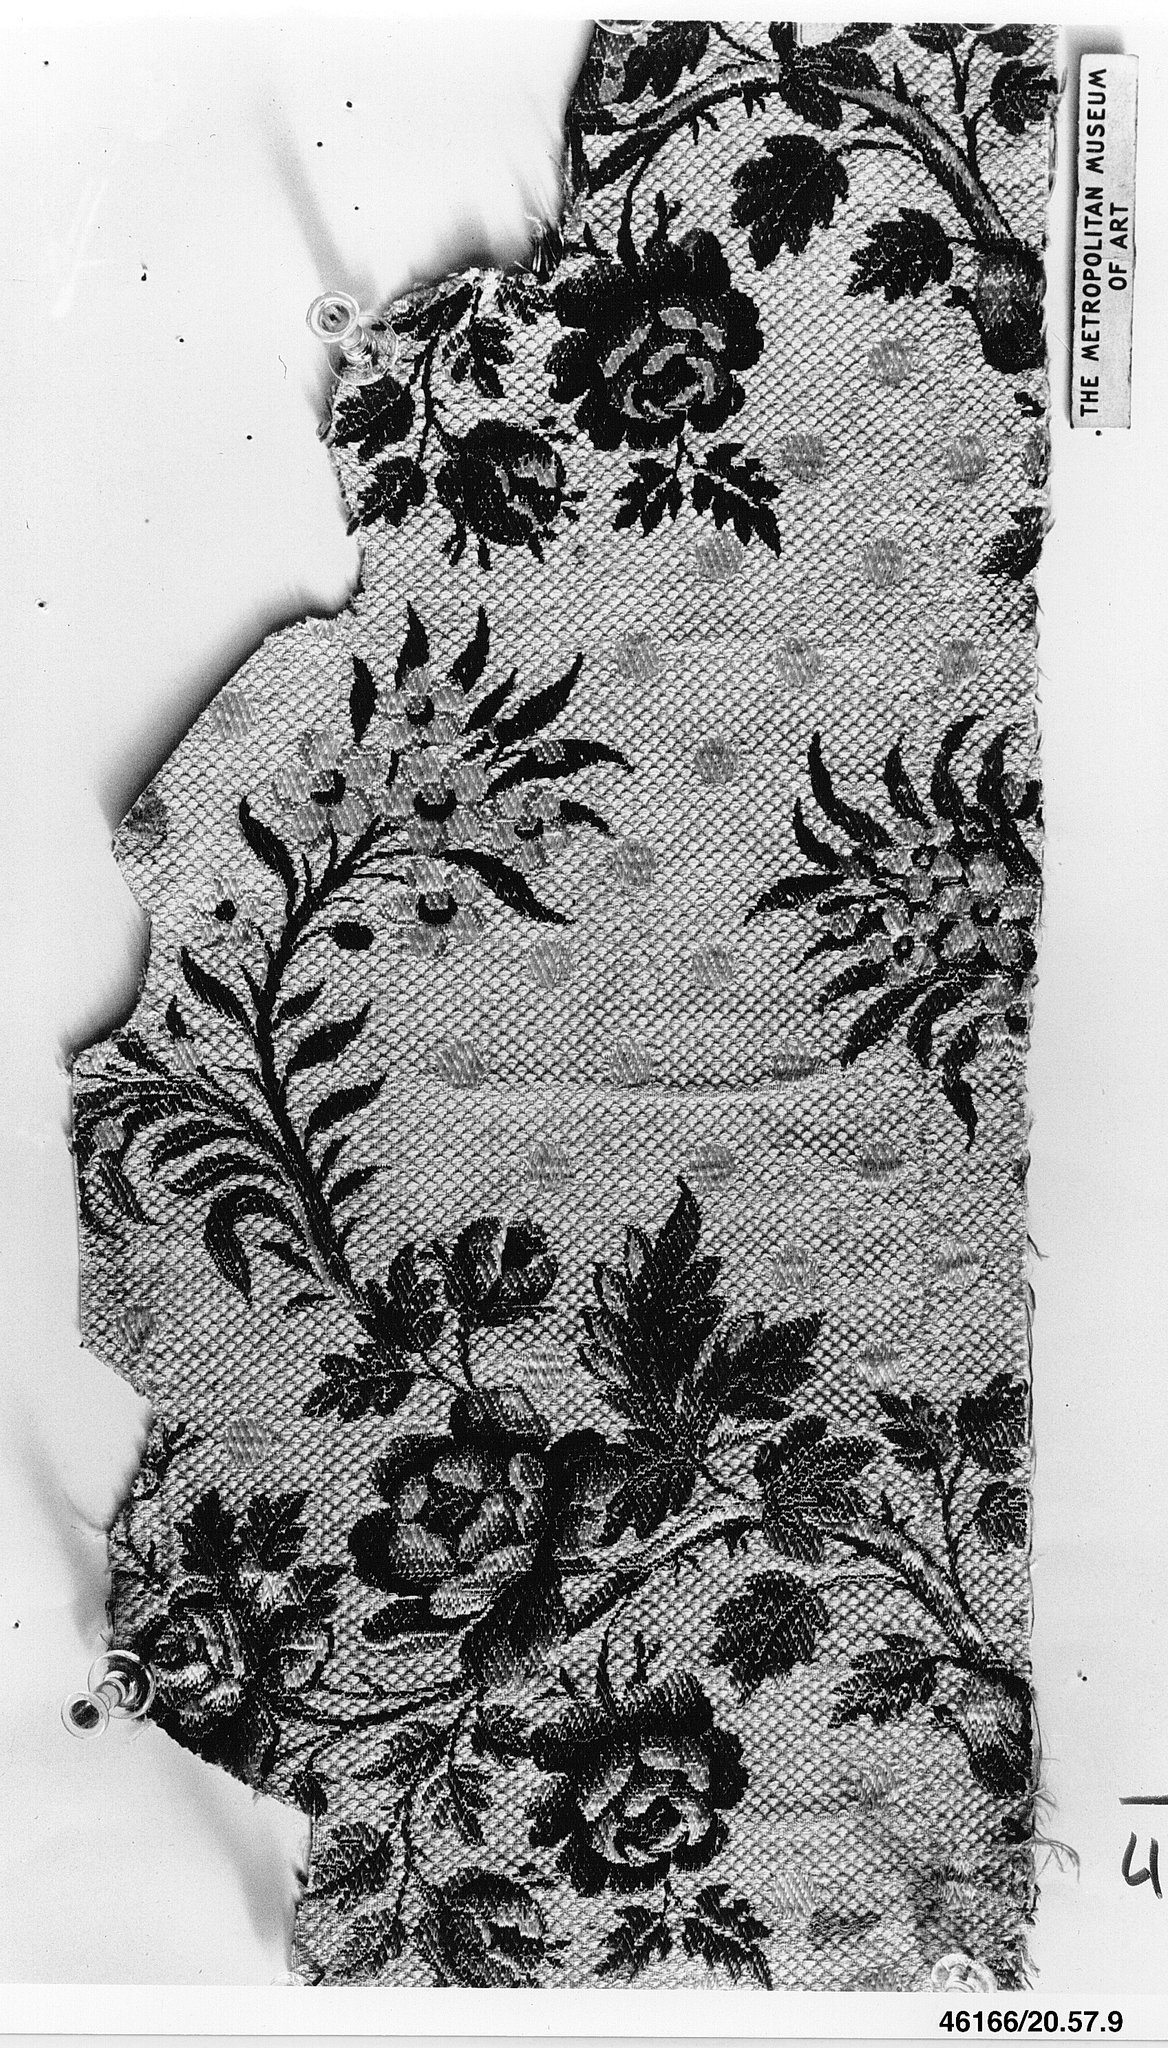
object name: fragment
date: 1740-1750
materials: silk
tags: flowers,leaves